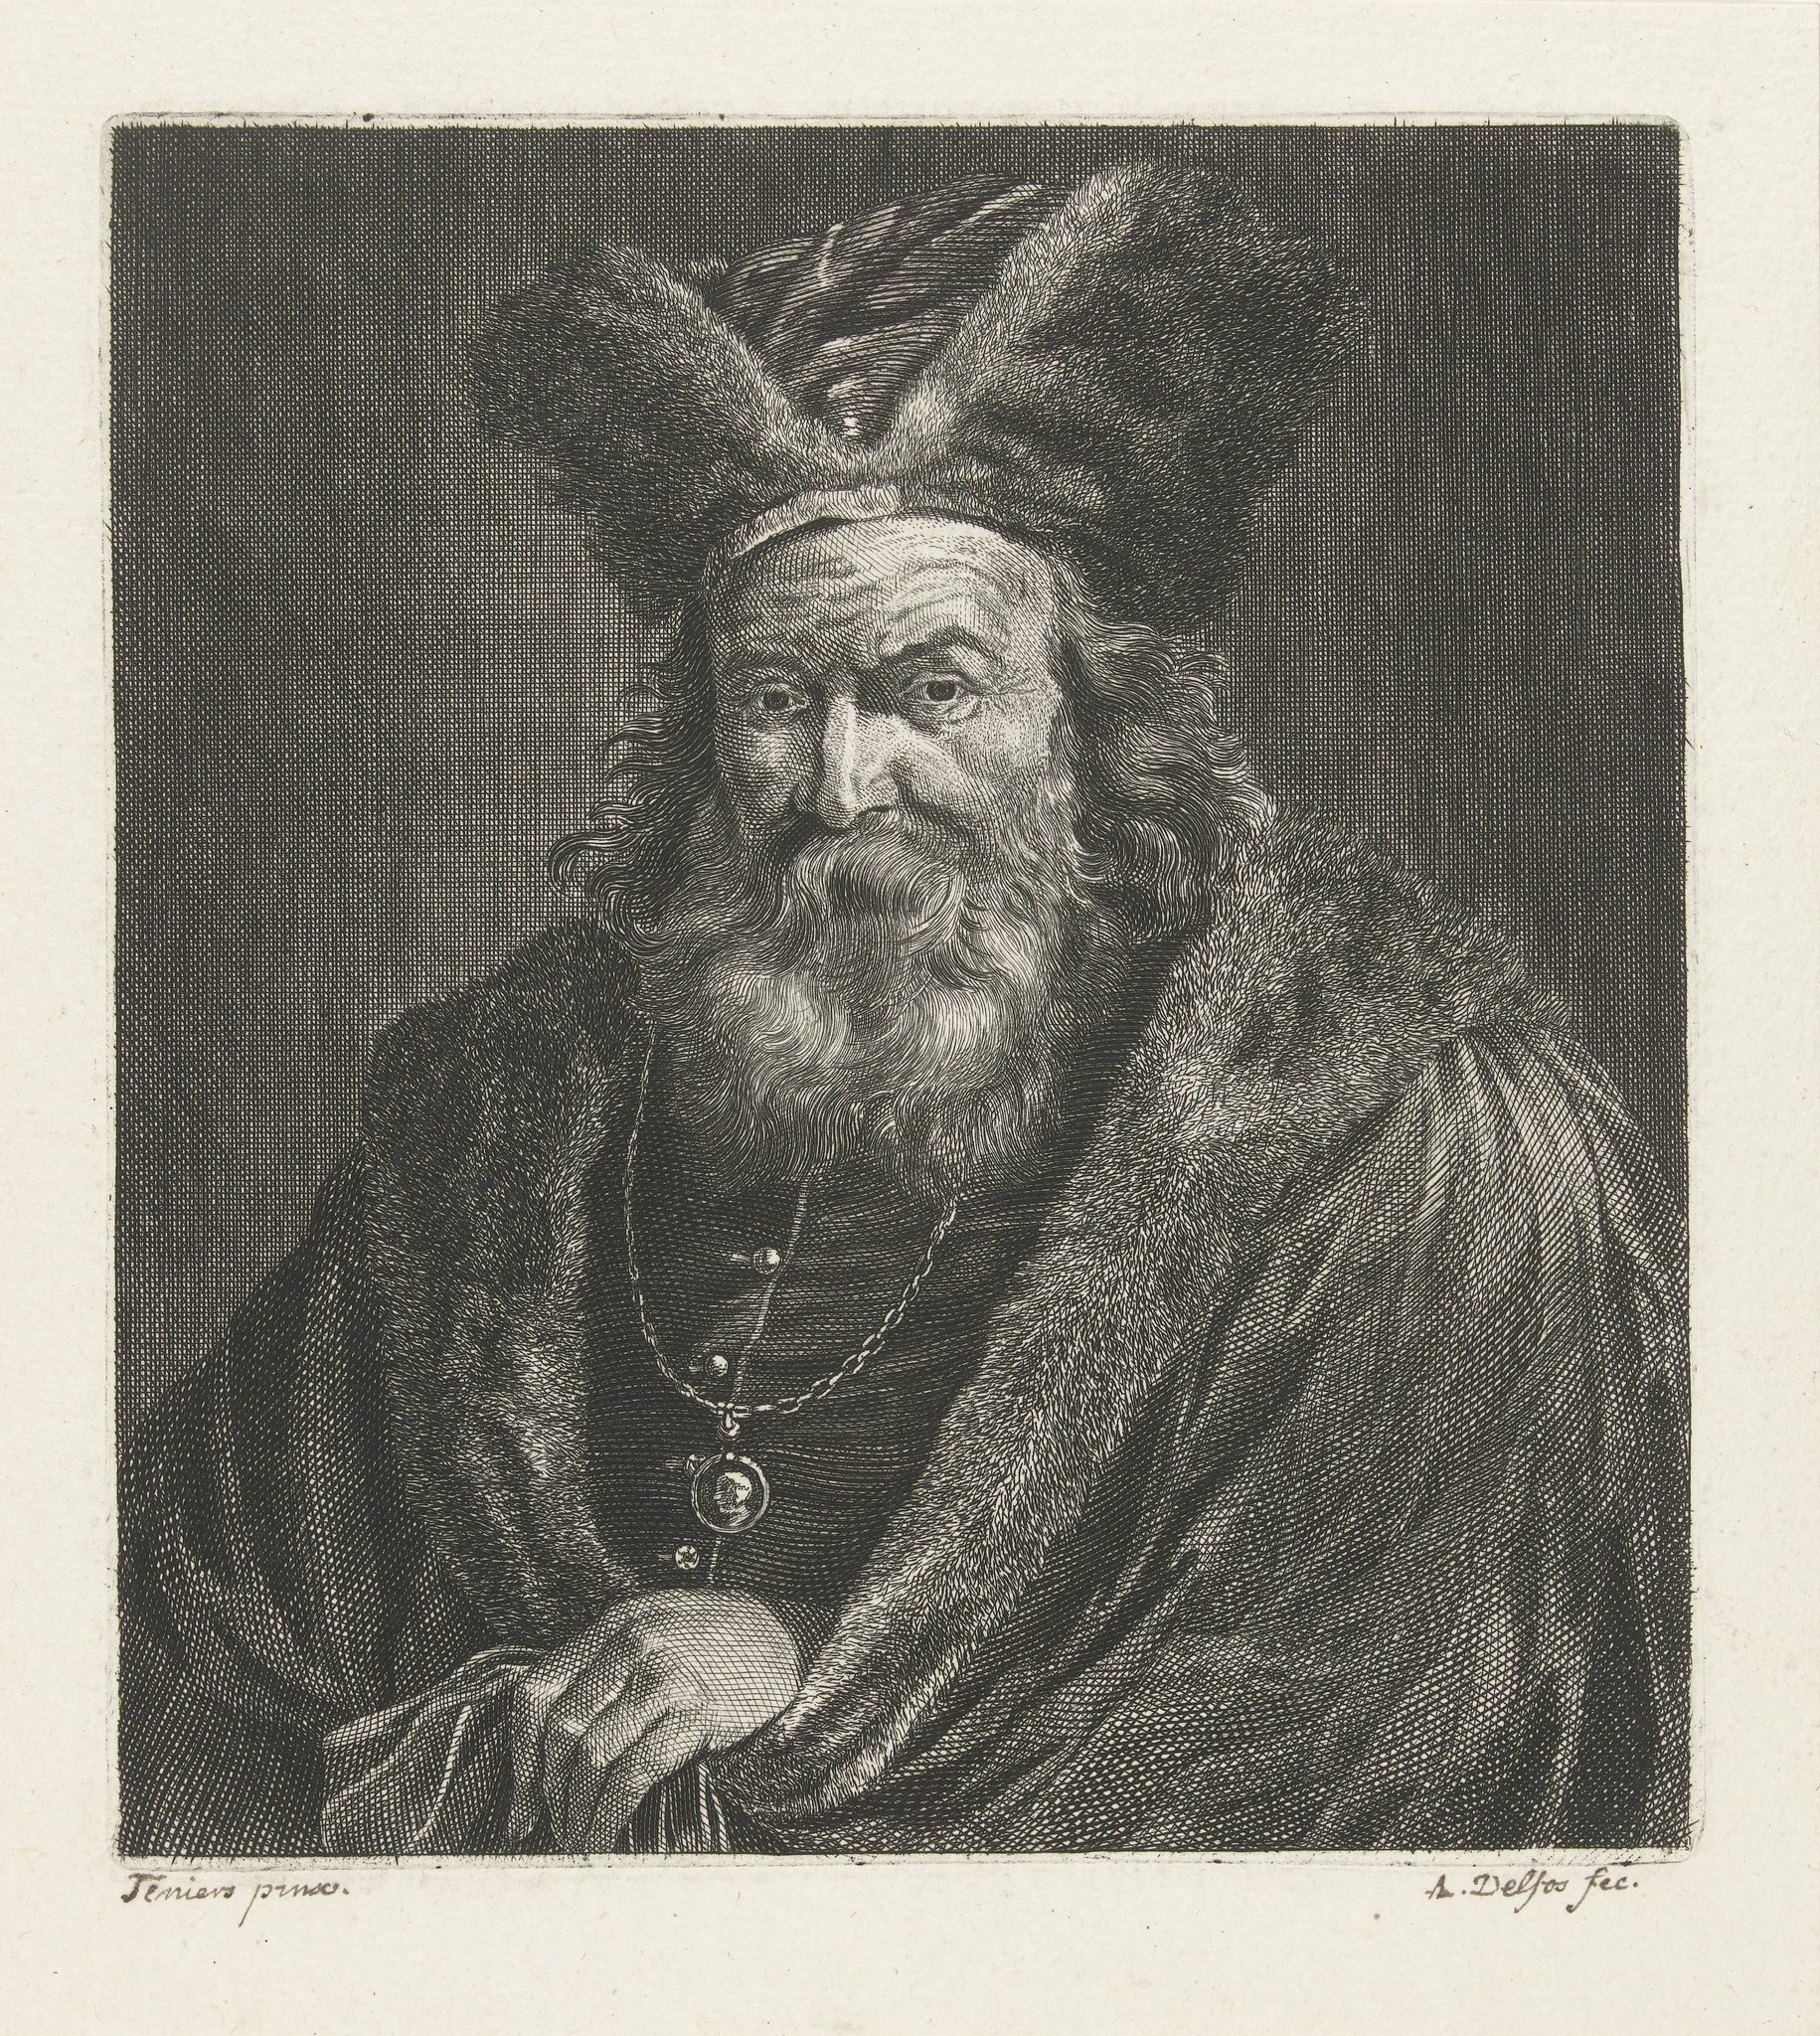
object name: print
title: Man met baard en bontmuts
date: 1741-1820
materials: paper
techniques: etching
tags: person with big beard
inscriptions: collector's mark: Lugt 240